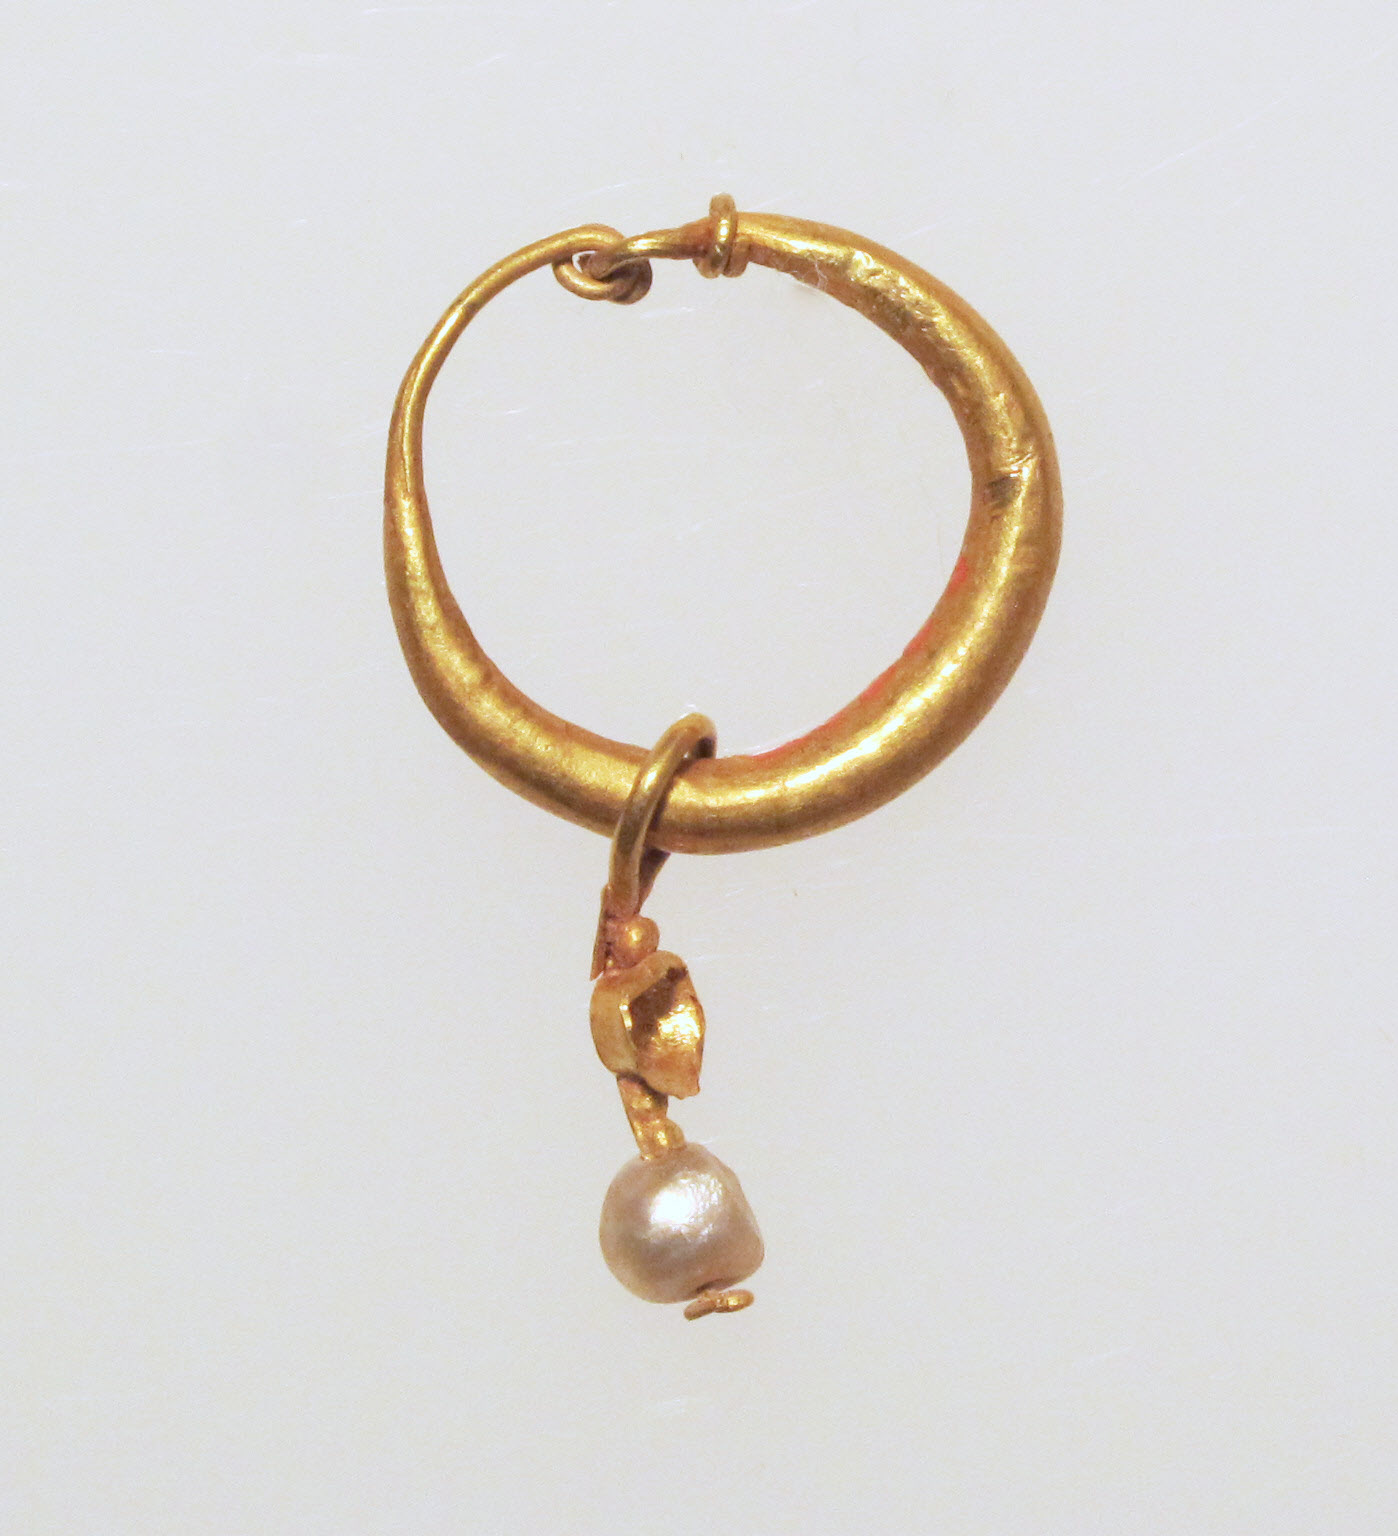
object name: earring with pendant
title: Gold earring with pearl pendant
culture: roman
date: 1-200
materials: gold